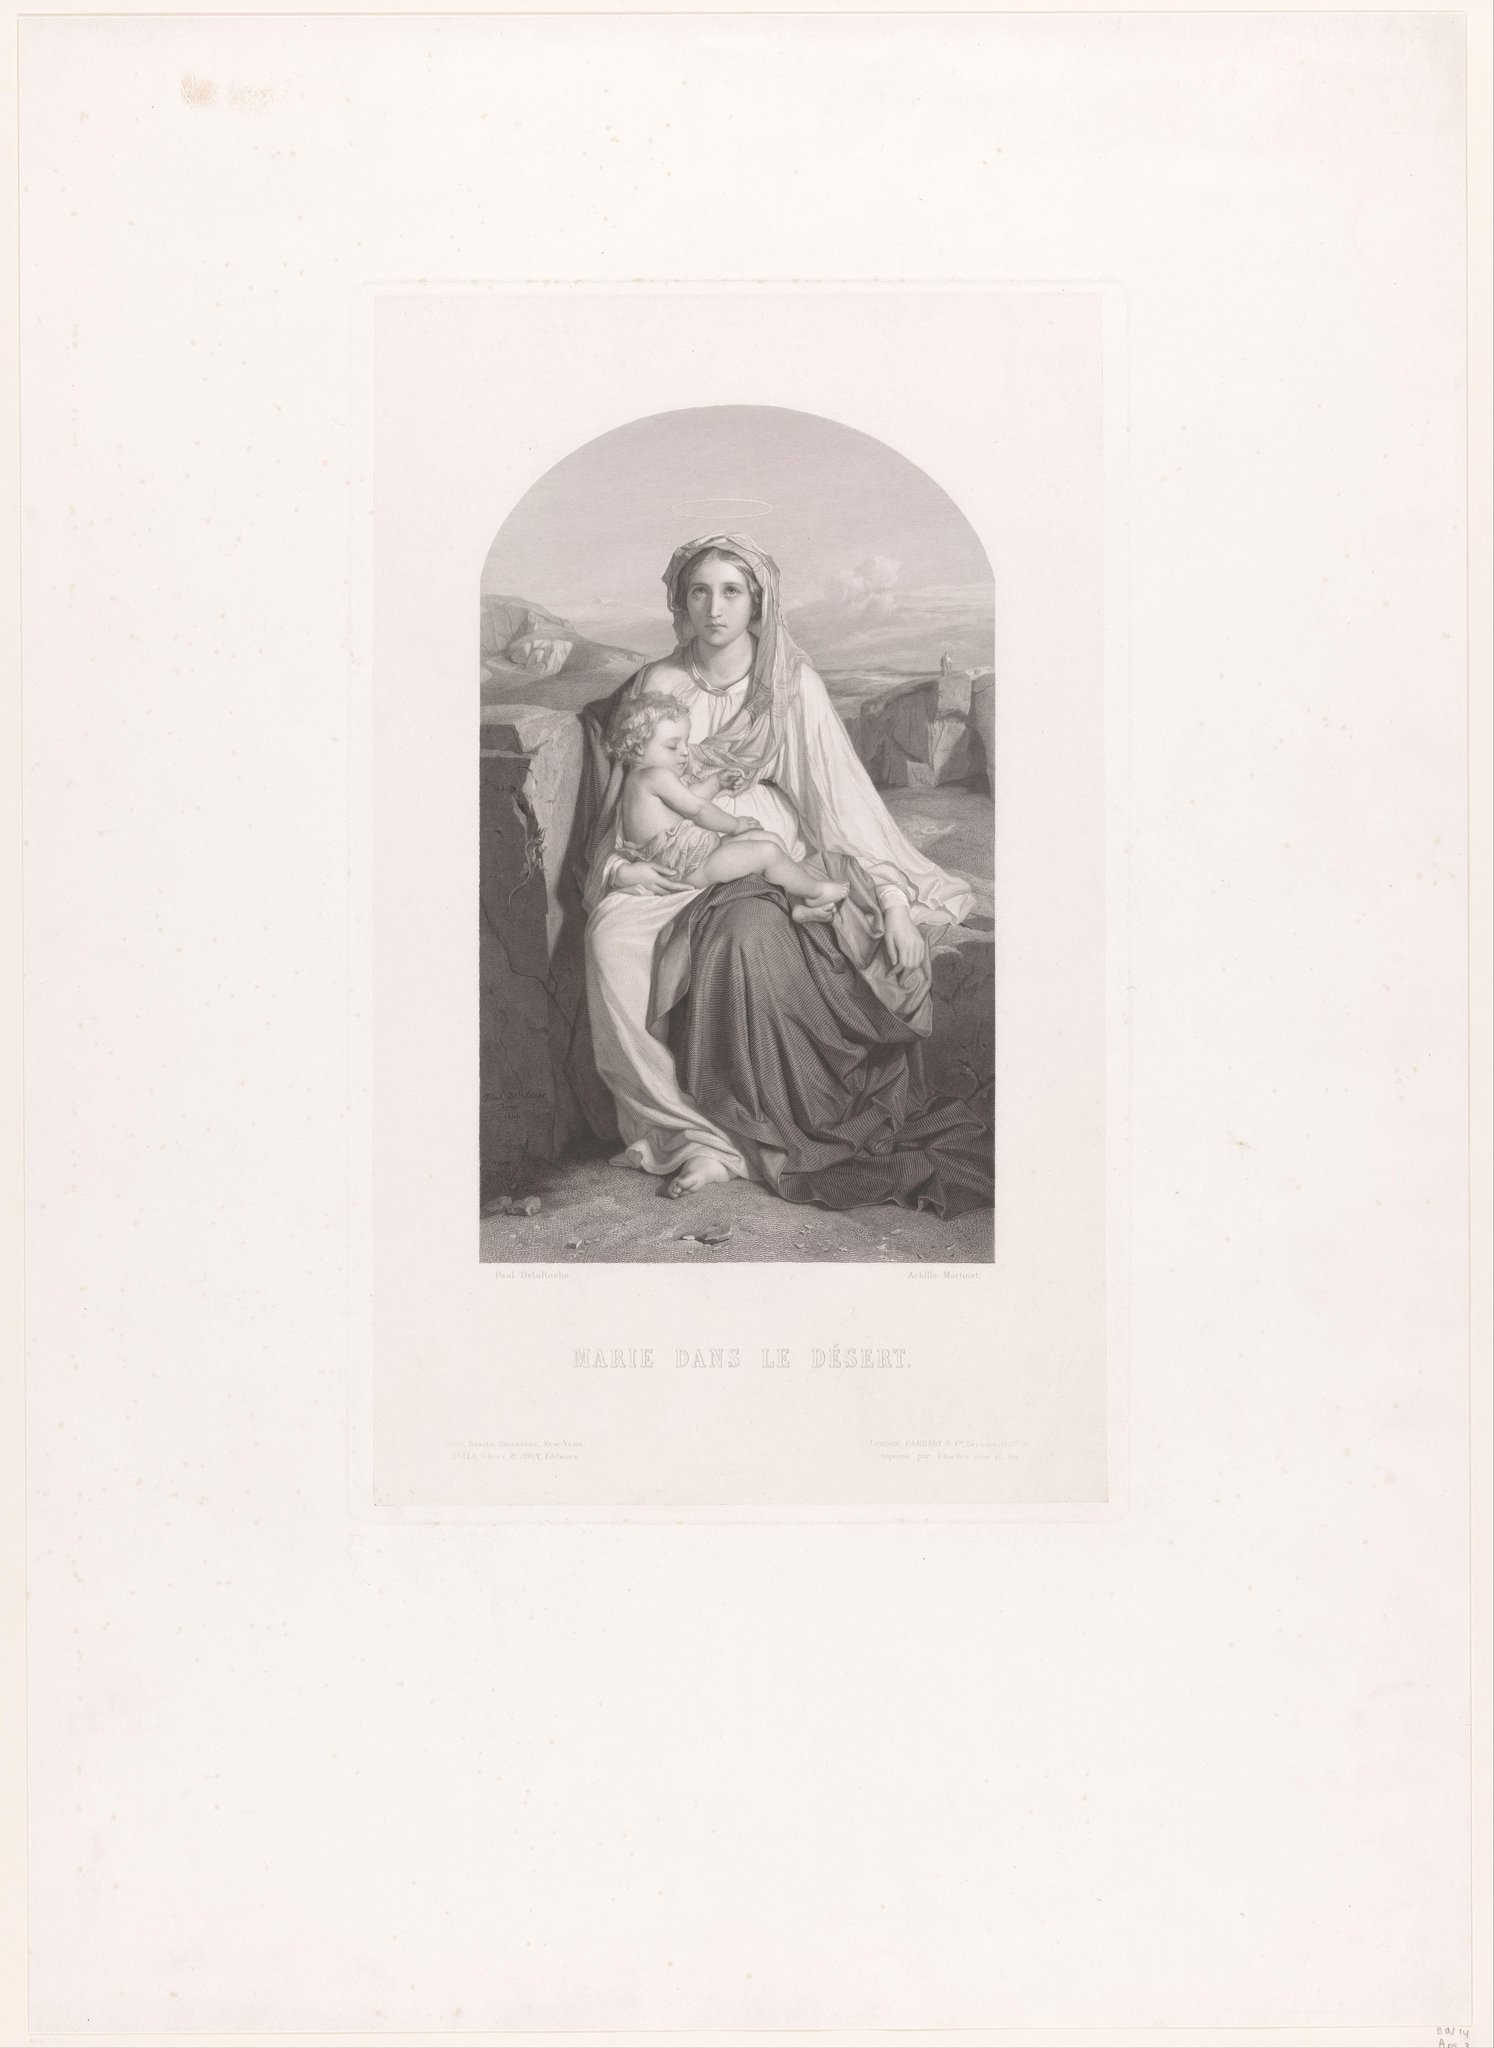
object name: print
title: Maria met Kind in de woestijn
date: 1846-1869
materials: paper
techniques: engraving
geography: rome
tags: mary sitting on the ground, the christ-child lying in mary's lap or on her knee (christ-child to mary's left)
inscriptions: collector's mark: Lugt 2228, check stamp